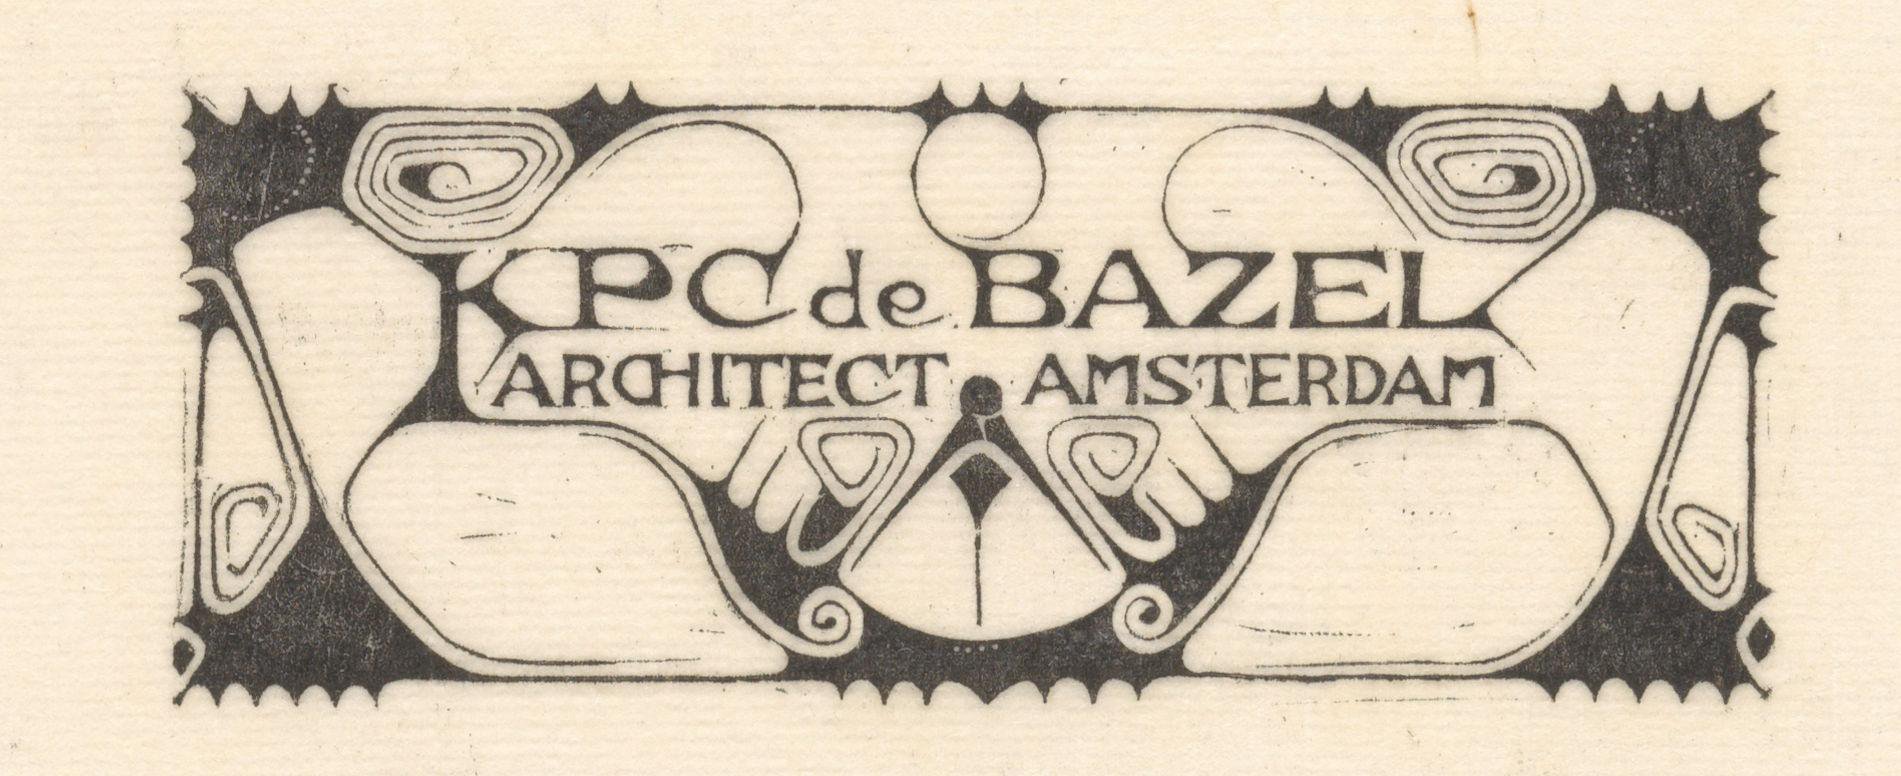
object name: print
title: Visitekaartje van Karel de Bazel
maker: karel petrus cornelis de bazel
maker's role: draughtsman, print maker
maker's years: 1869-1923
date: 1896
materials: paper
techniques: woodcut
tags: amsterdam, print maker, draughtsman, karel petrus cornelis de bazel, visiting-card, calling-card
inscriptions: collector's mark: Lugt 2228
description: Visitekaartje van K.P.C. de Bazel, architect, Amsterdam.